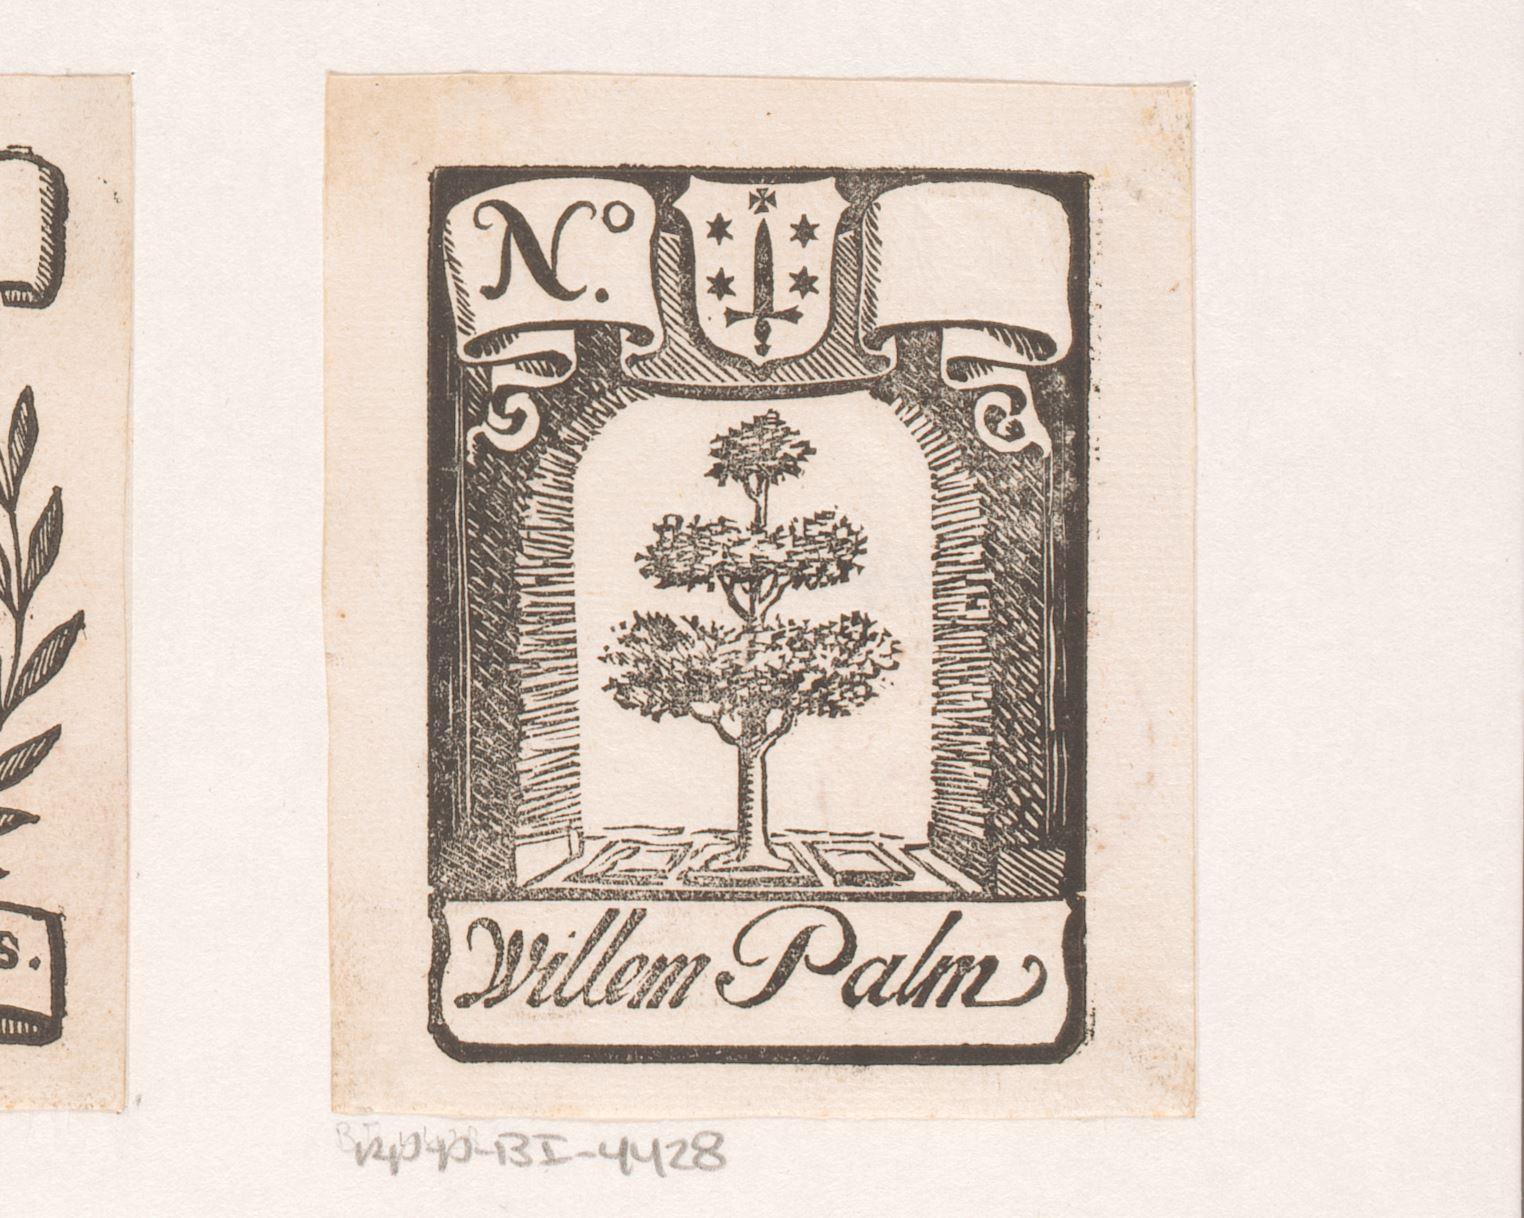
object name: print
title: Vignet van Willem Palm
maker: Anonymous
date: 1600-1699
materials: paper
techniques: woodcut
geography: netherlands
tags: coat of arms (as symbol of the state, etc.) (+ city; municipal), trees, vignette, haarlem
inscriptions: collector's mark: Lugt 240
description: Een boom onder een toog. Midden boven het wapen van de stad Haarlem.